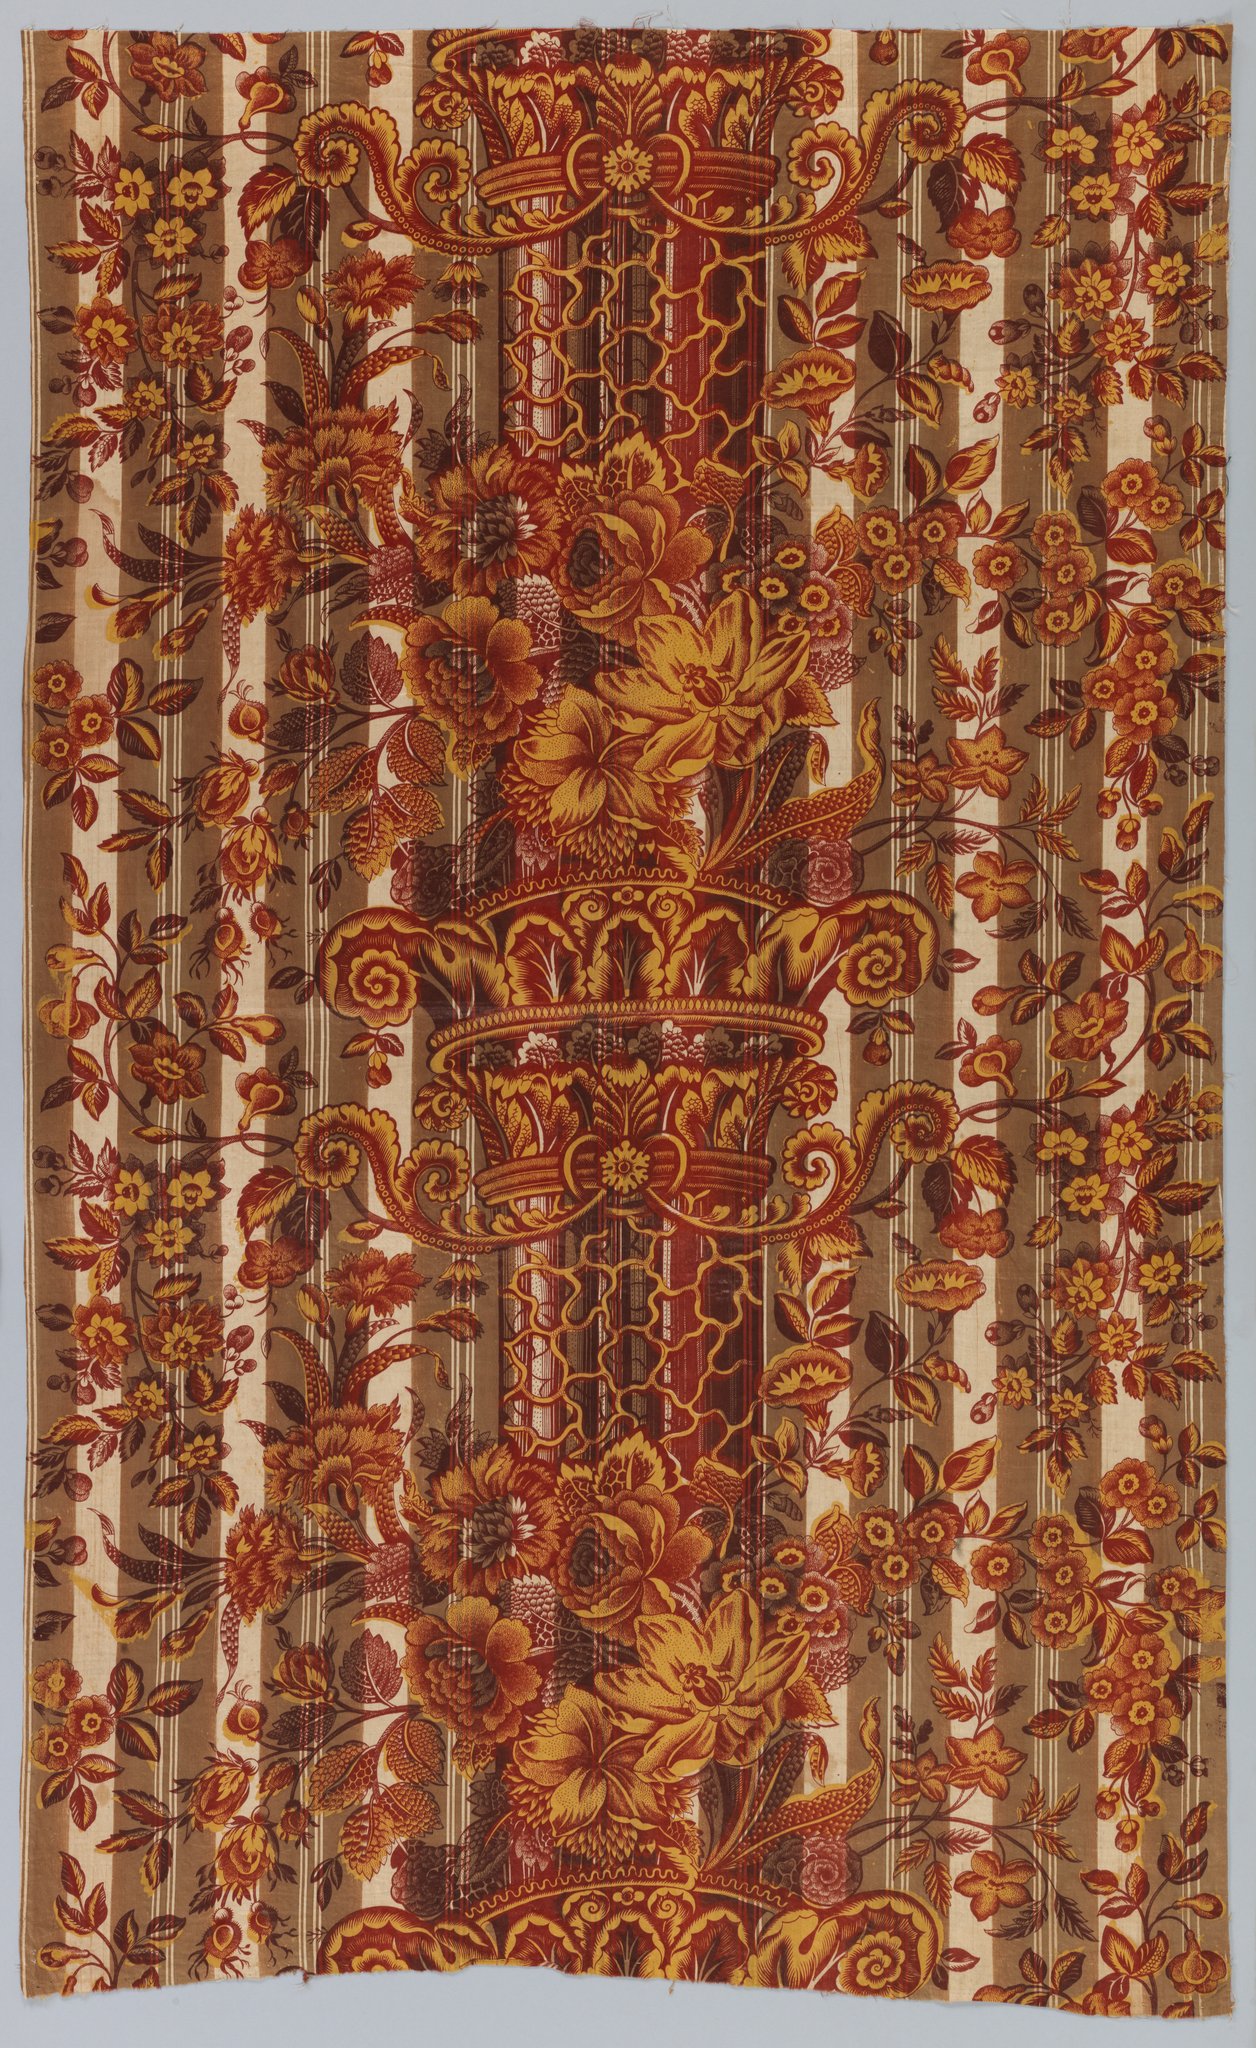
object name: piece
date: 1824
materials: cotton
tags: flowers,leaves